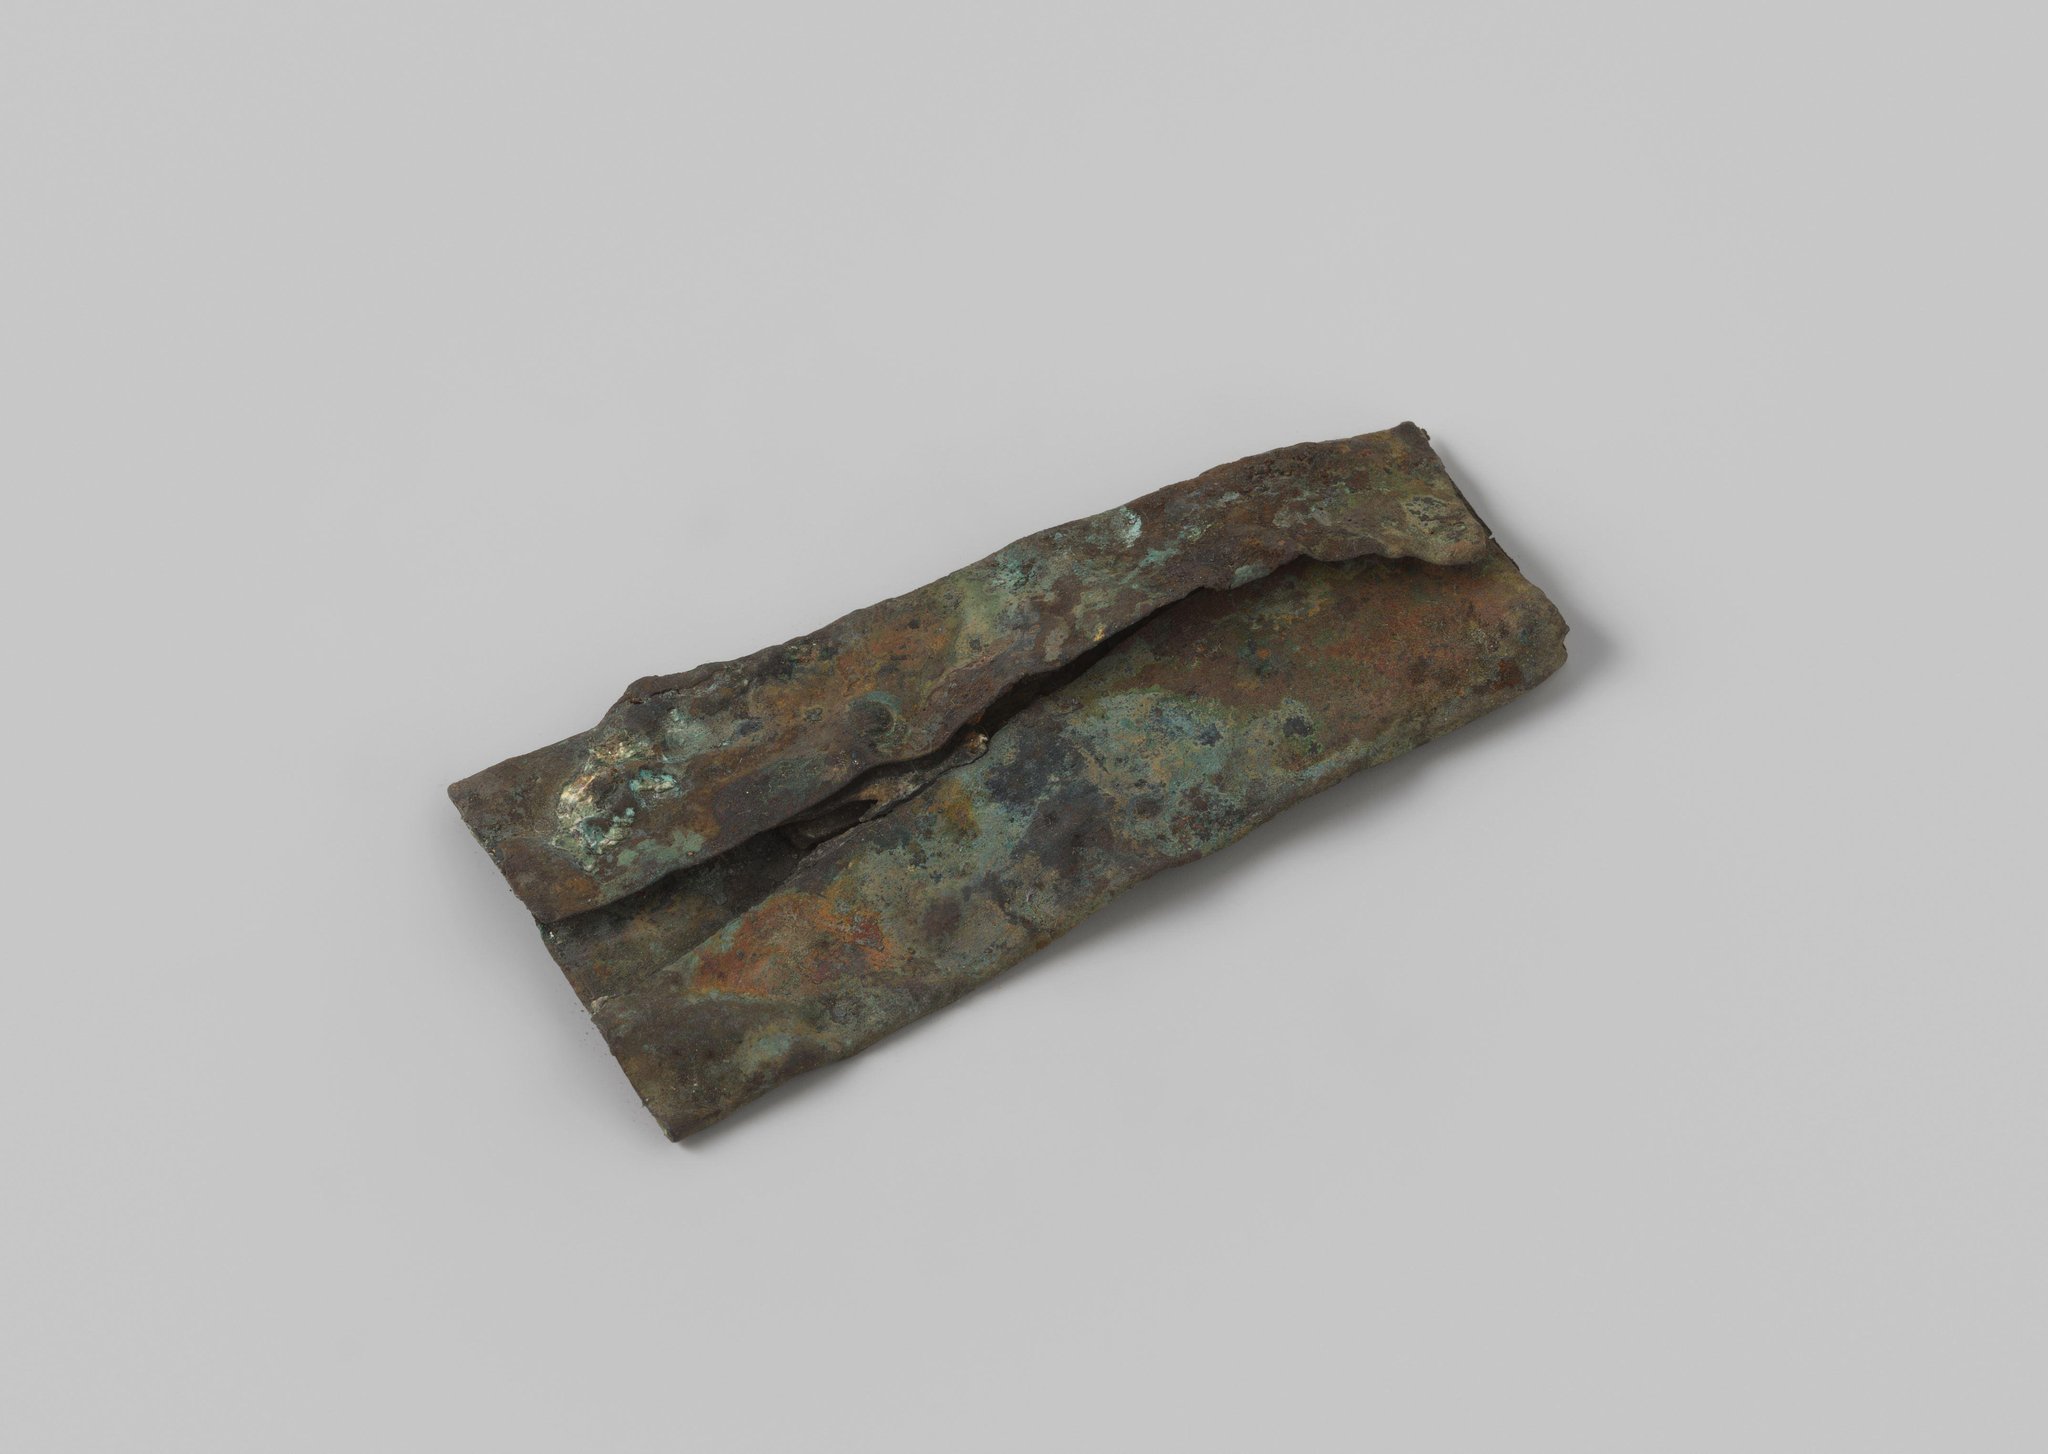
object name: cartridge shell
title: Patroonhuls uit het wrak van de Oost-Indiëvaarder Hollandia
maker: Anonymous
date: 1700-1743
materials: copper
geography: netherlands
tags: verenigde oostindische compagnie, hollandia (schip), annet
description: Cartridge case, tube; squashed, id. NG 1979-205H549.